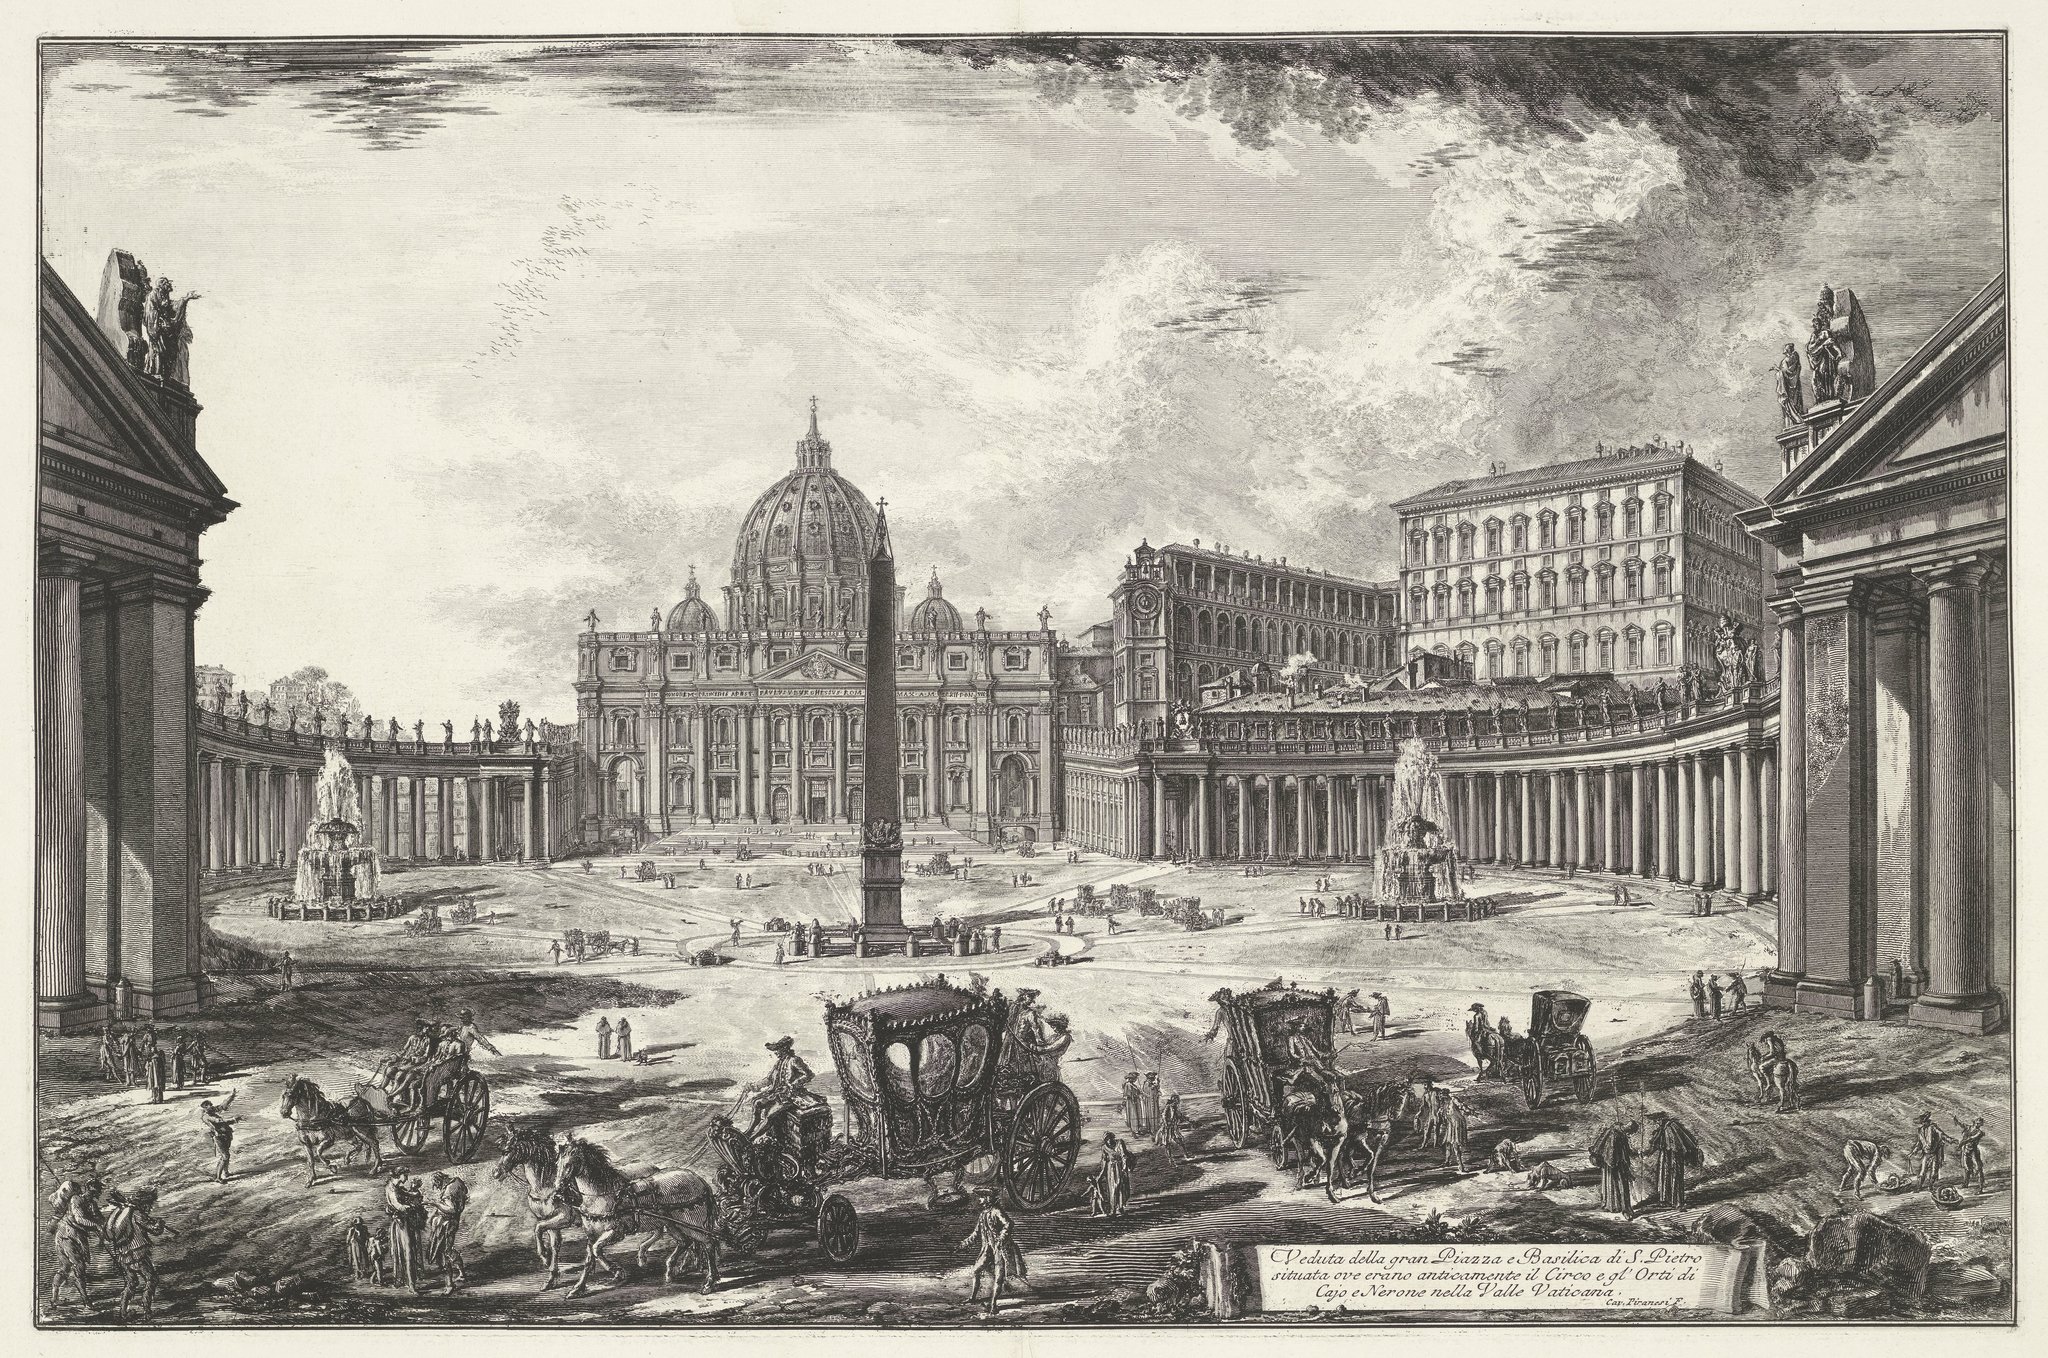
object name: print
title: Veduta della gran Piazza e Basilica di S. Pietro (...)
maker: giovanni battista piranesi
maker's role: designer, draughtsman, print maker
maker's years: 1720-1778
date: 1748-1778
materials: paper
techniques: etching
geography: rome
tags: square, place, circus, etc., city-view, and landscape with man-made constructions, church (exterior), roman catholic church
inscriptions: collector's mark: Lugt 2228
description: Deze prent maakt deel uit van de serie 'Vedute di Roma'. Piranesi werkte aan deze 135 platen tellende serie tussen 1748 en zijn dood in 1778. Francesco Piranesi voegde later nog twee prenten toe aan de reeks van zijn vader.